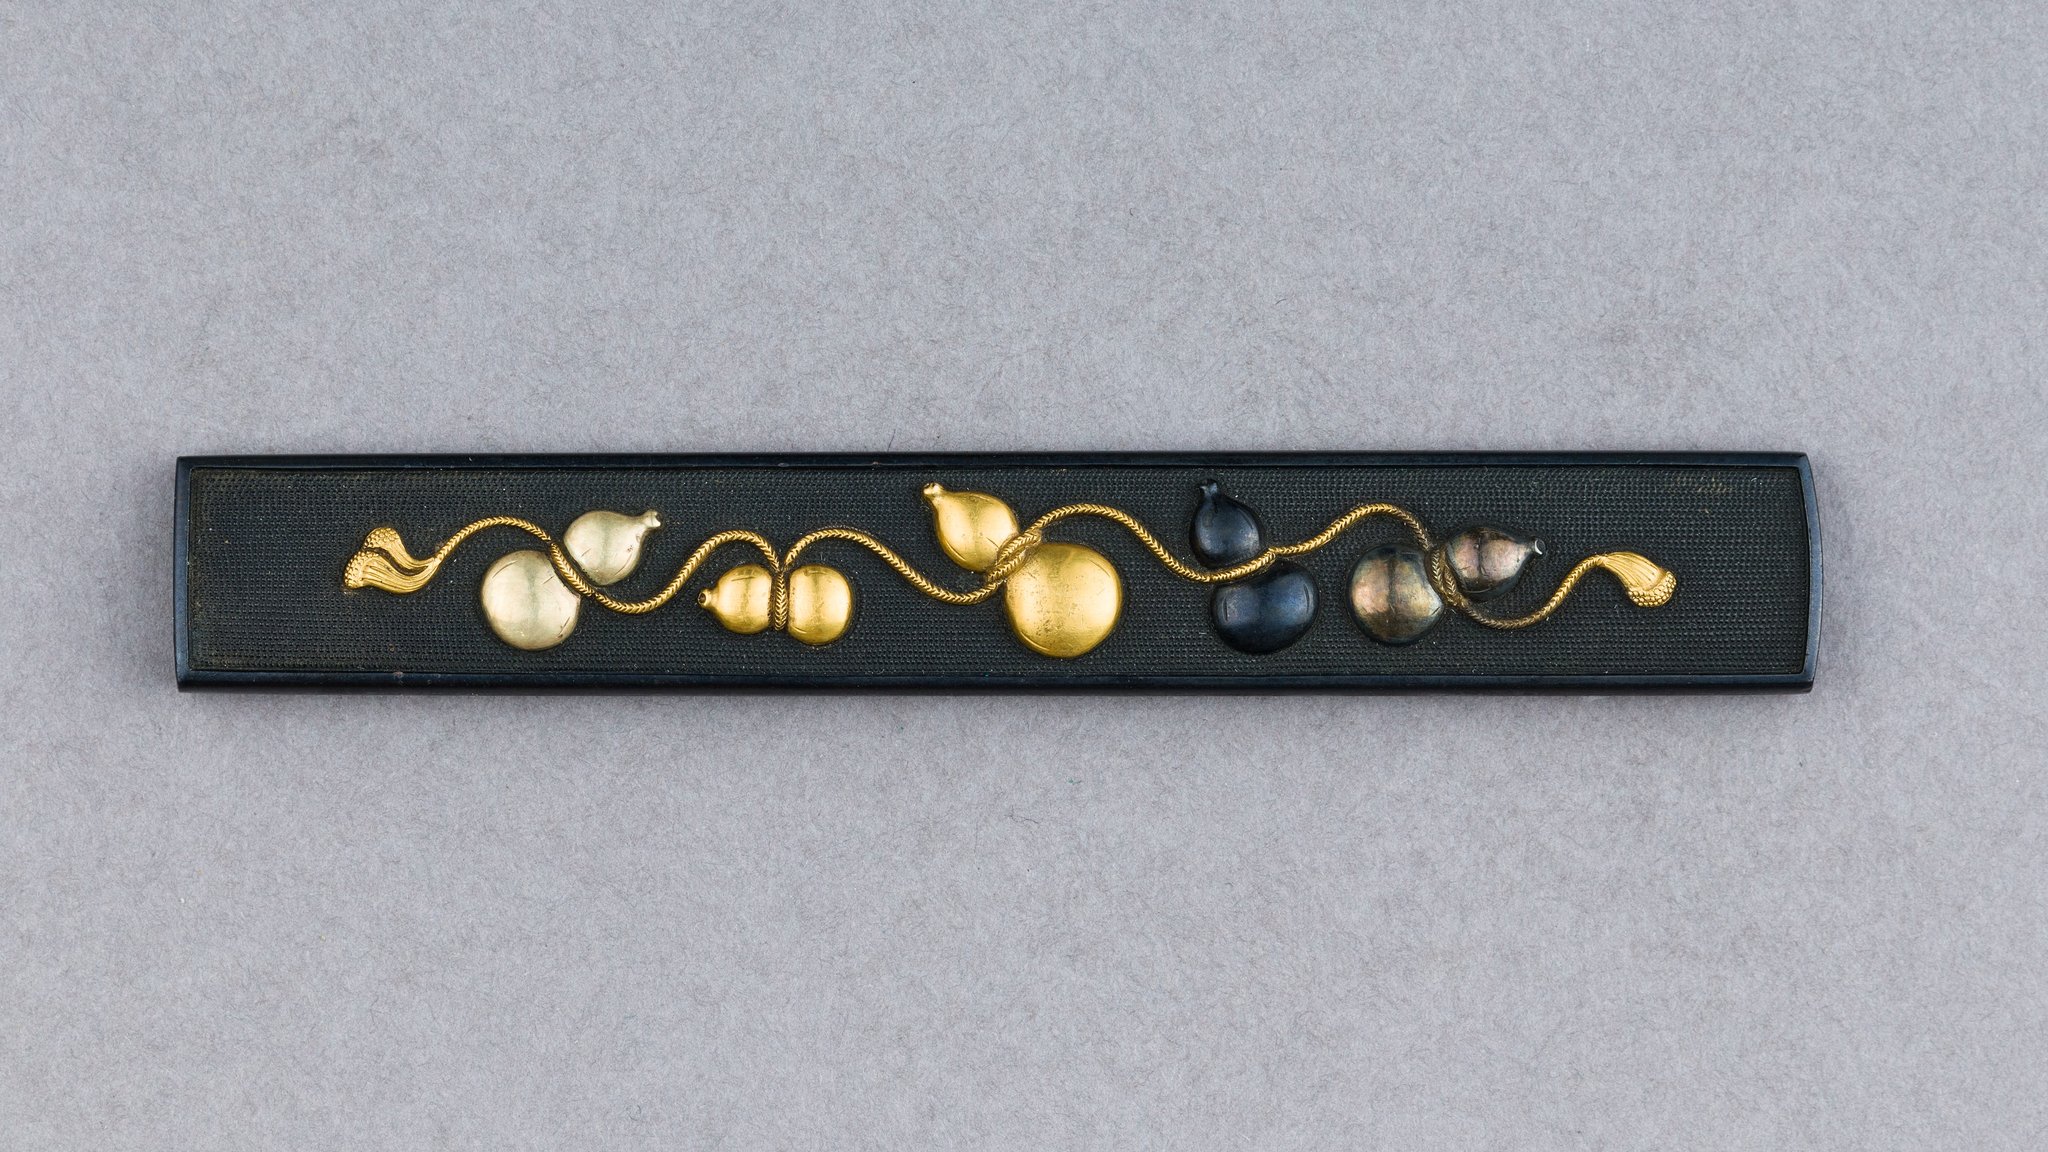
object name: knife handle kozuka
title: Knife Handle (Kozuka)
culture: japanese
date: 1615-1868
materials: gold alloy, gold, silver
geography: japan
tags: gourds